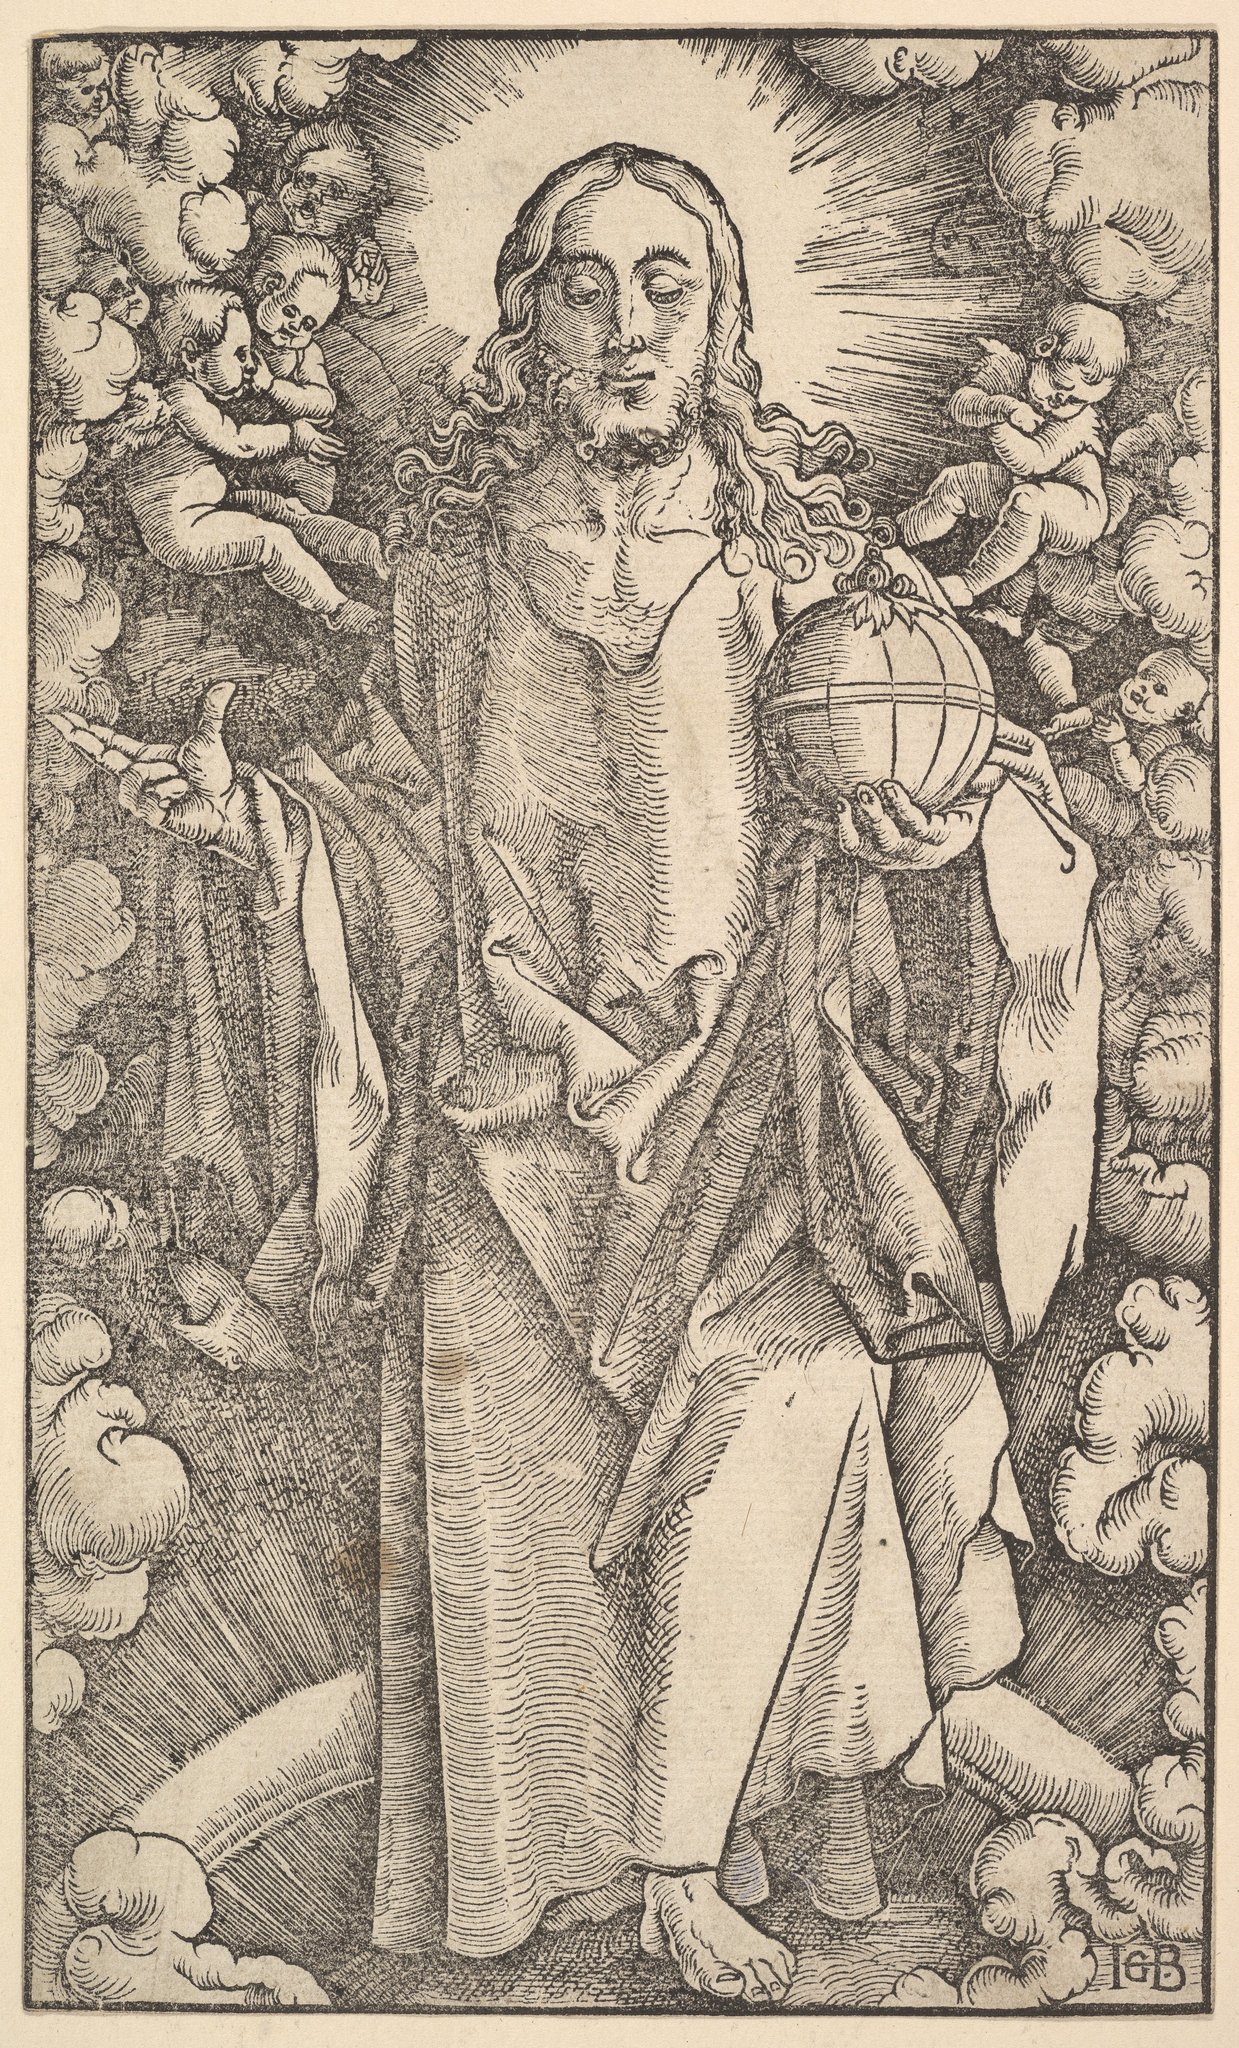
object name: print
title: Christ from Christ and the Apostles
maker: hans baldung (called hans baldung grien)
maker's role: artist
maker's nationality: german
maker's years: 1484-1545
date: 1519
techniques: woodcut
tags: angels,christ